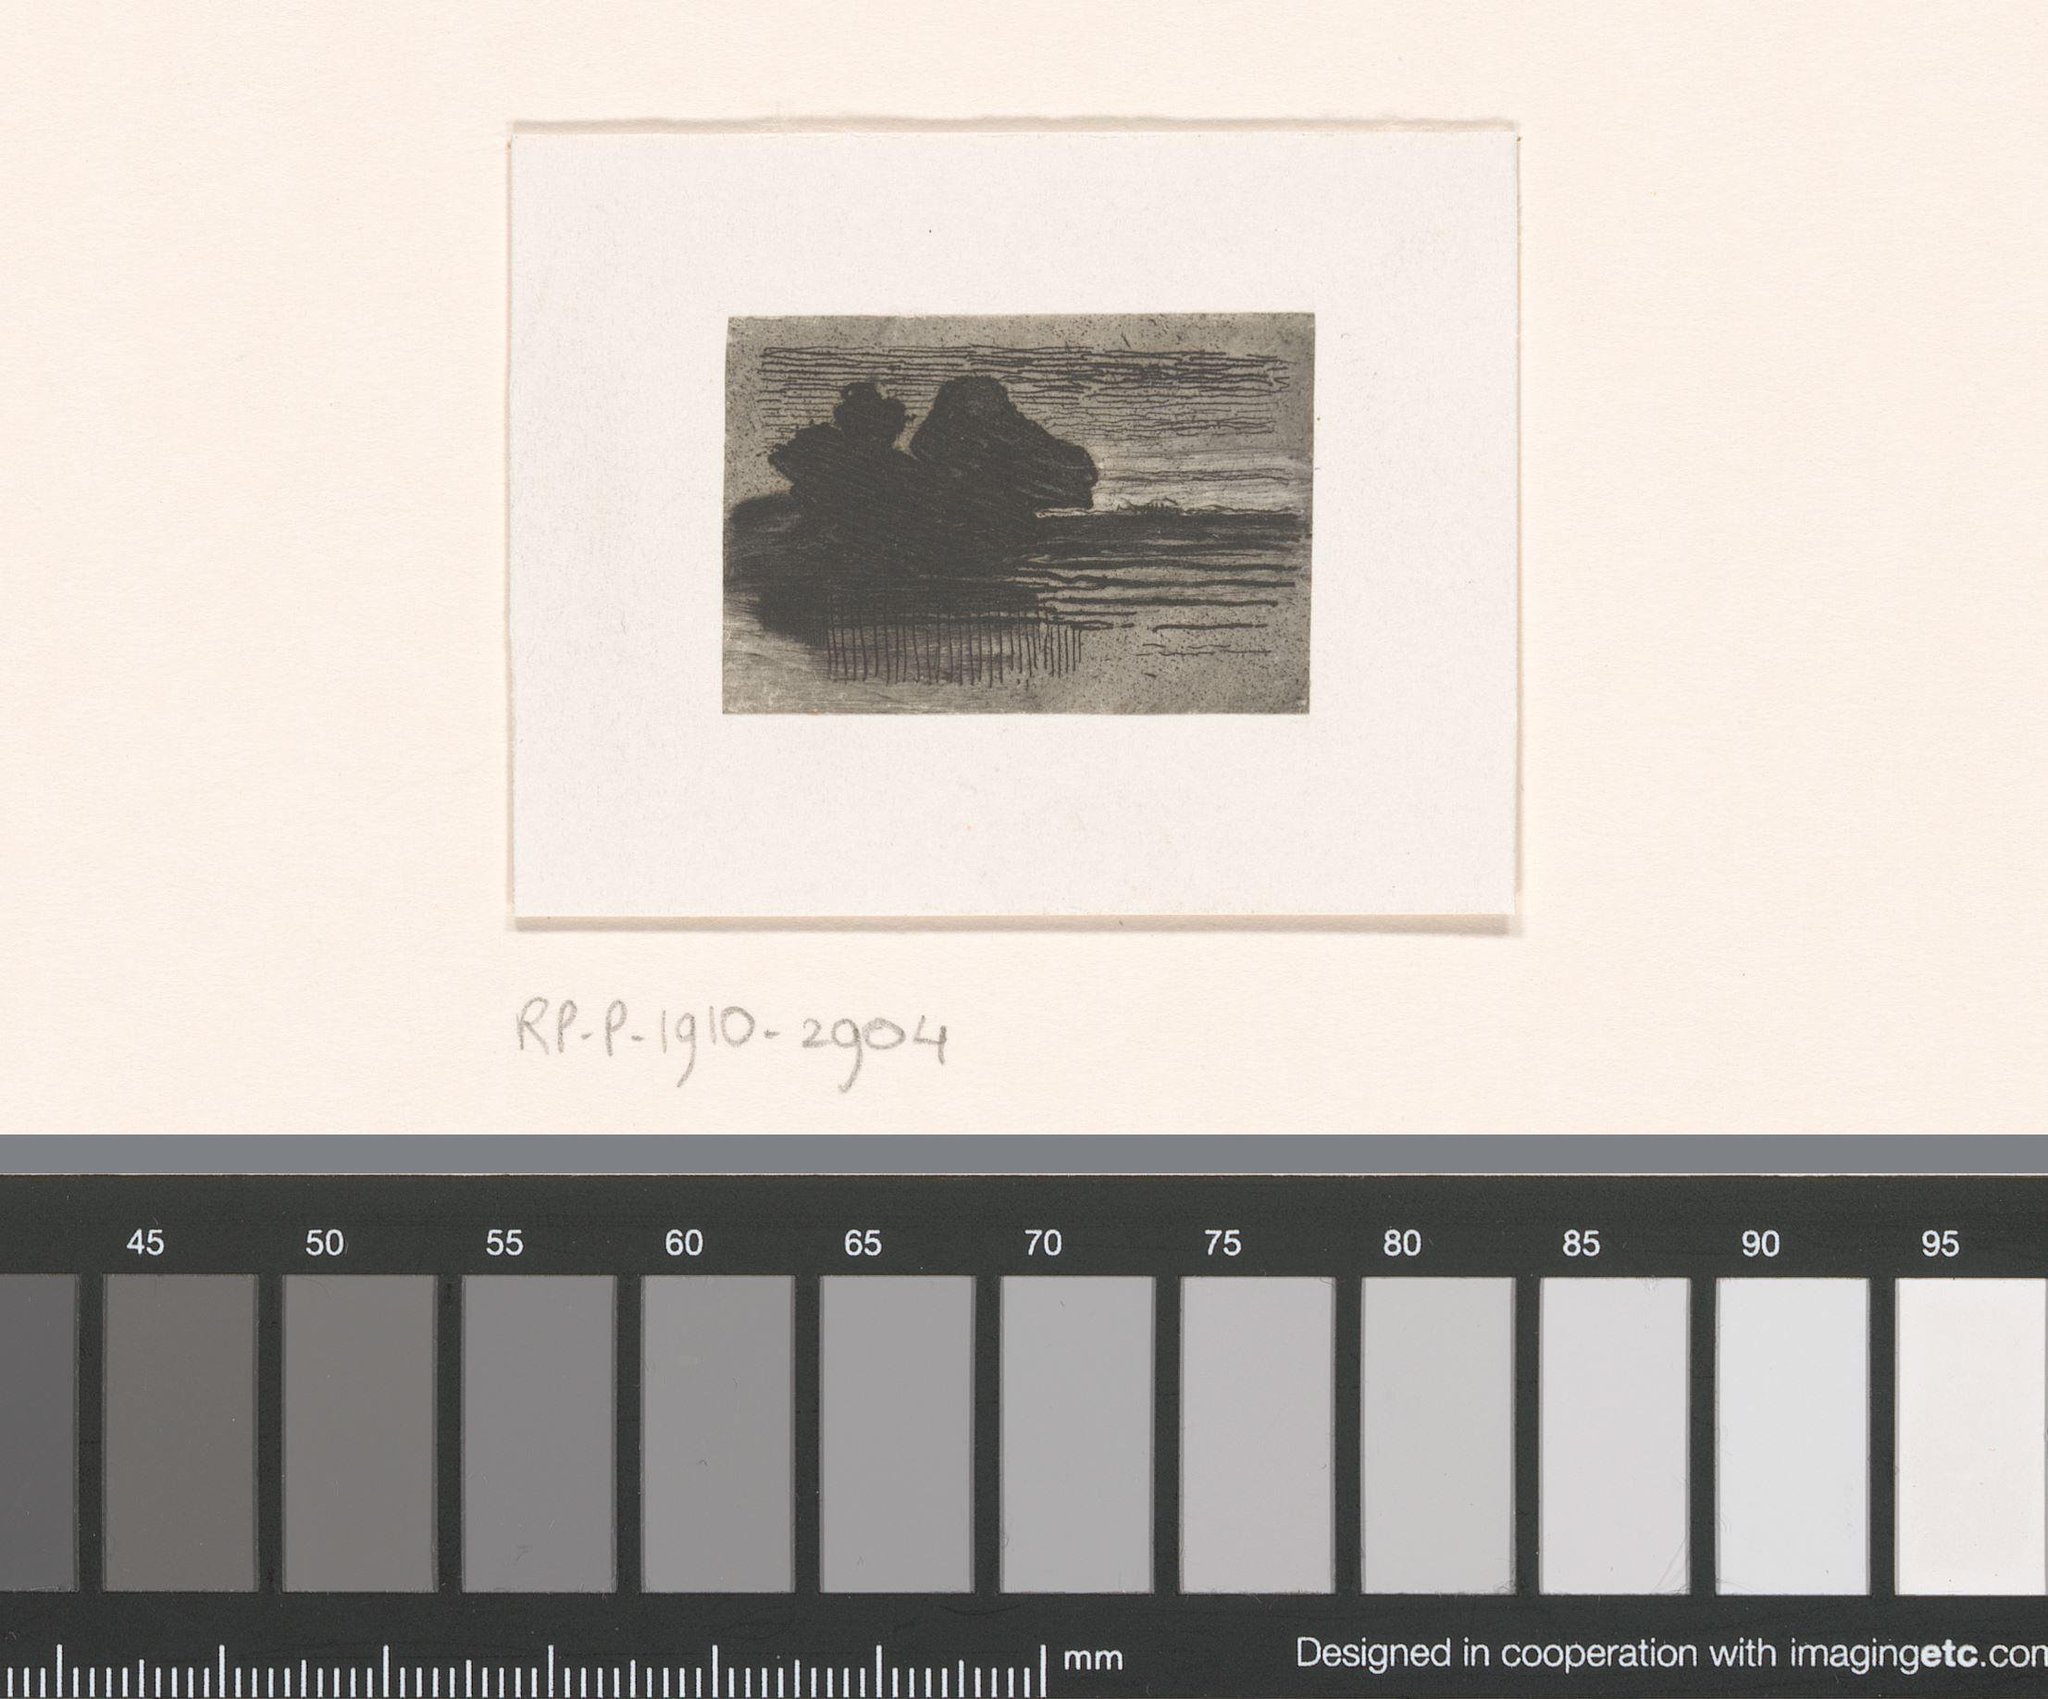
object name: print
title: Boomgroep bij avond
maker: carel nicolaas storm van s-gravesande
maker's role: draughtsman, print maker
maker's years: 1841-1924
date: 1851-1910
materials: paper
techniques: etching, intaglio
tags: trees, evening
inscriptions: collector's mark: Lugt 2228